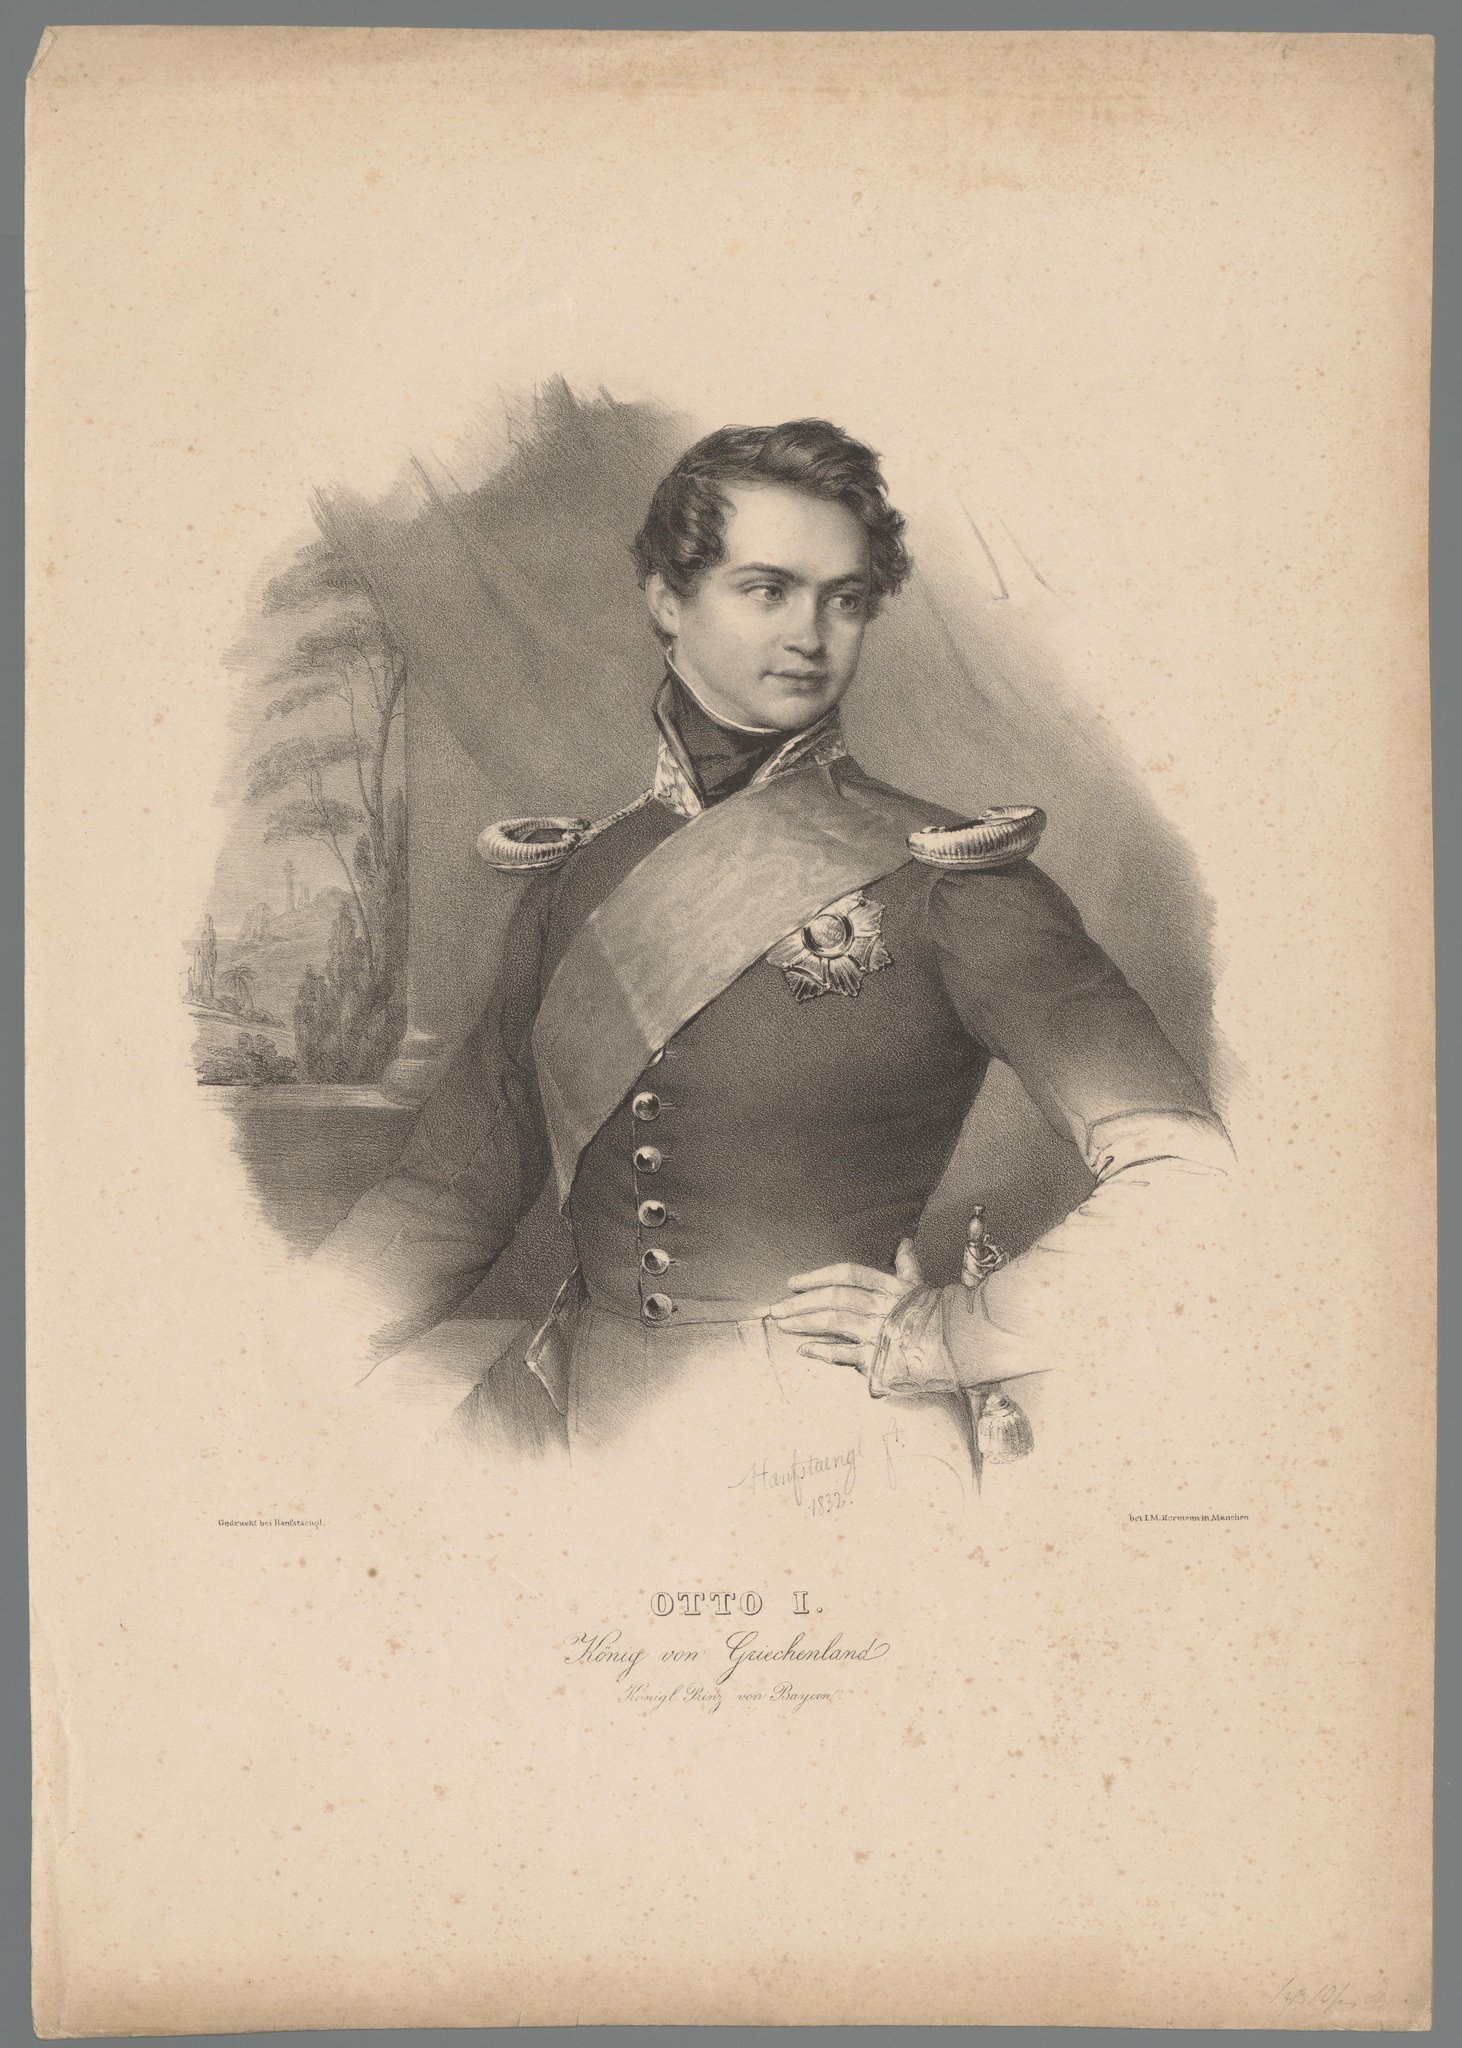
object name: print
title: Portret van Otto I, koning van Griekenland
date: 1832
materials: paper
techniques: lithograph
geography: munich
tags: historical persons, youth, adolescent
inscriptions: collector's mark: Lugt 2228